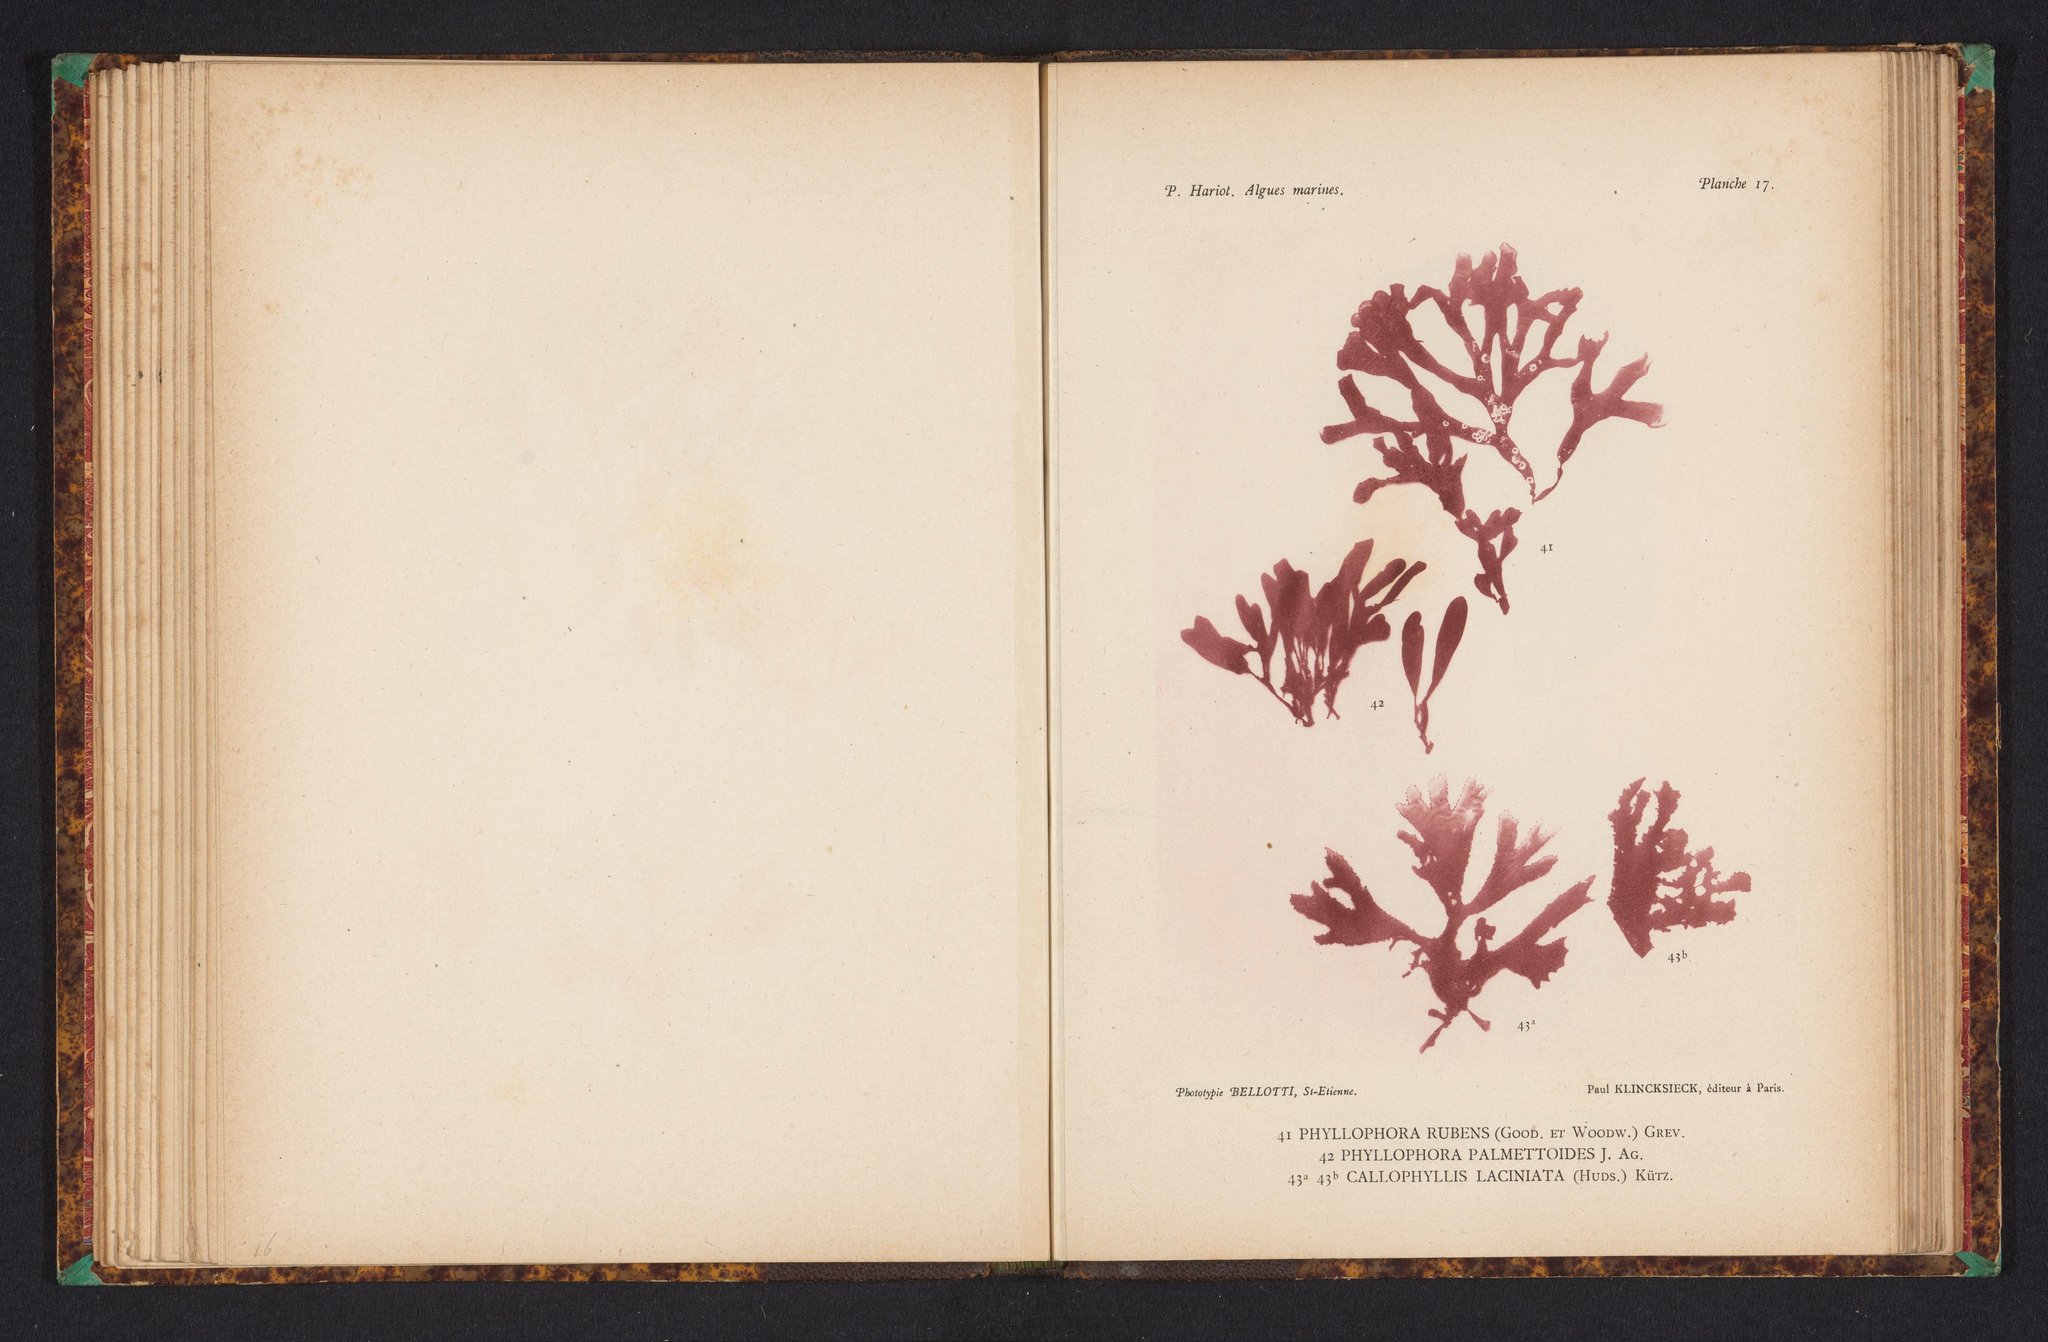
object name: page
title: Drie soorten zeewier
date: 1882-1892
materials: paper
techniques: photograph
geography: france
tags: algae, seaweed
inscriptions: inscription: ‘Phyllophora (...) (Huds.) Kütz.’, number: ‘41 (...) 43b.’, number: ‘Planche 17.’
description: (41) is Phyllophora rubens, (42) is Phyllophora palmettoides, (43a) en (43b) is Callophyllis laciniata.